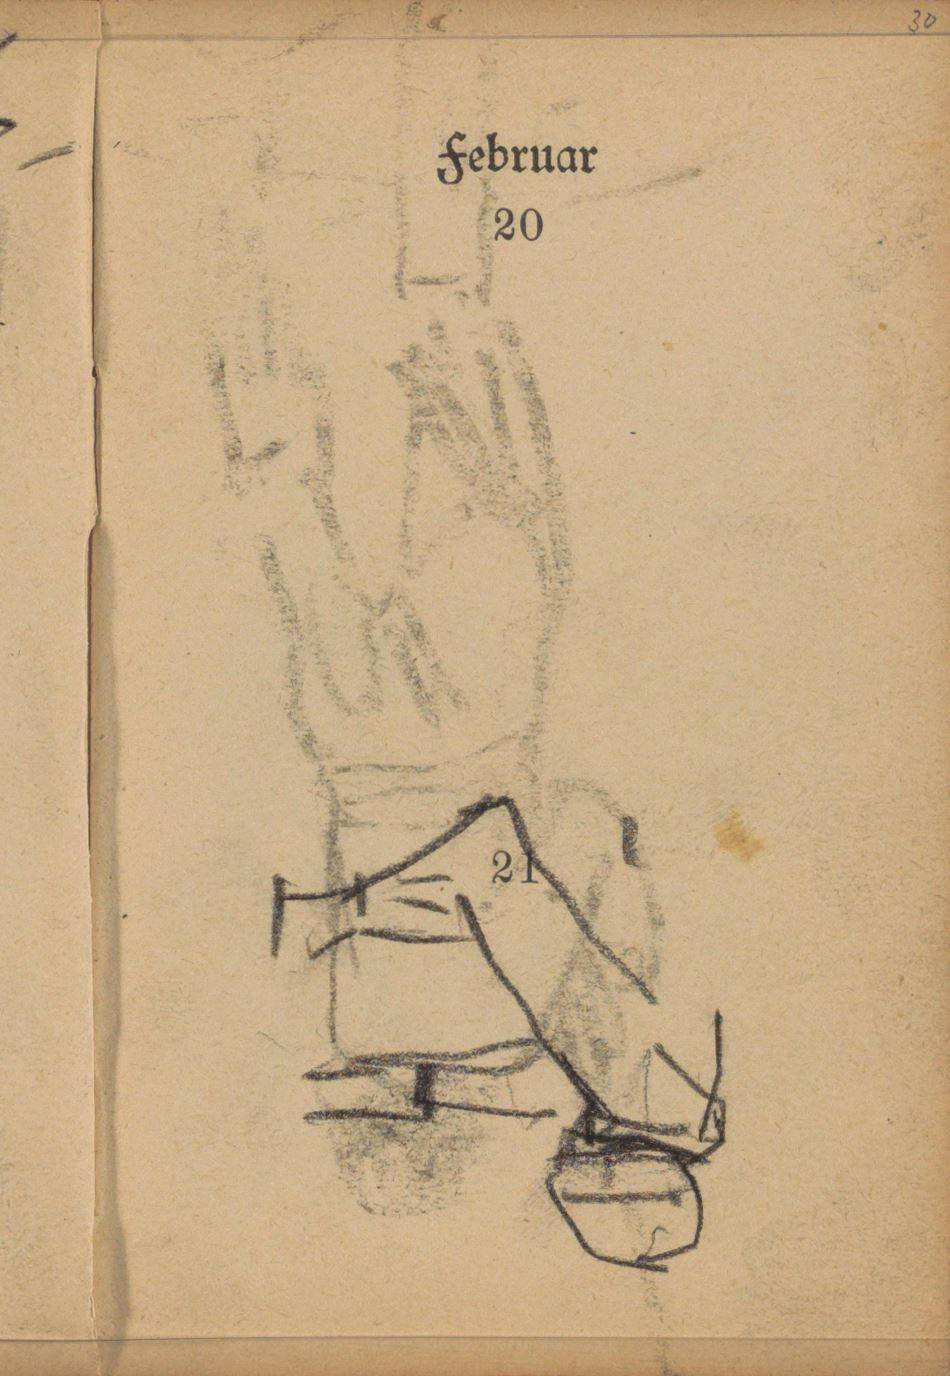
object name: sketchbook leaf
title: Figuurstudie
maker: george hendrik breitner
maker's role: draughtsman, painter, print maker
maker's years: 1857-1923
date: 1893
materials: chalk, paper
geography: amsterdam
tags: adult woman, adult man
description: Pagina 30 uit een als schetsboek gebruikte agenda met 80 bladen.